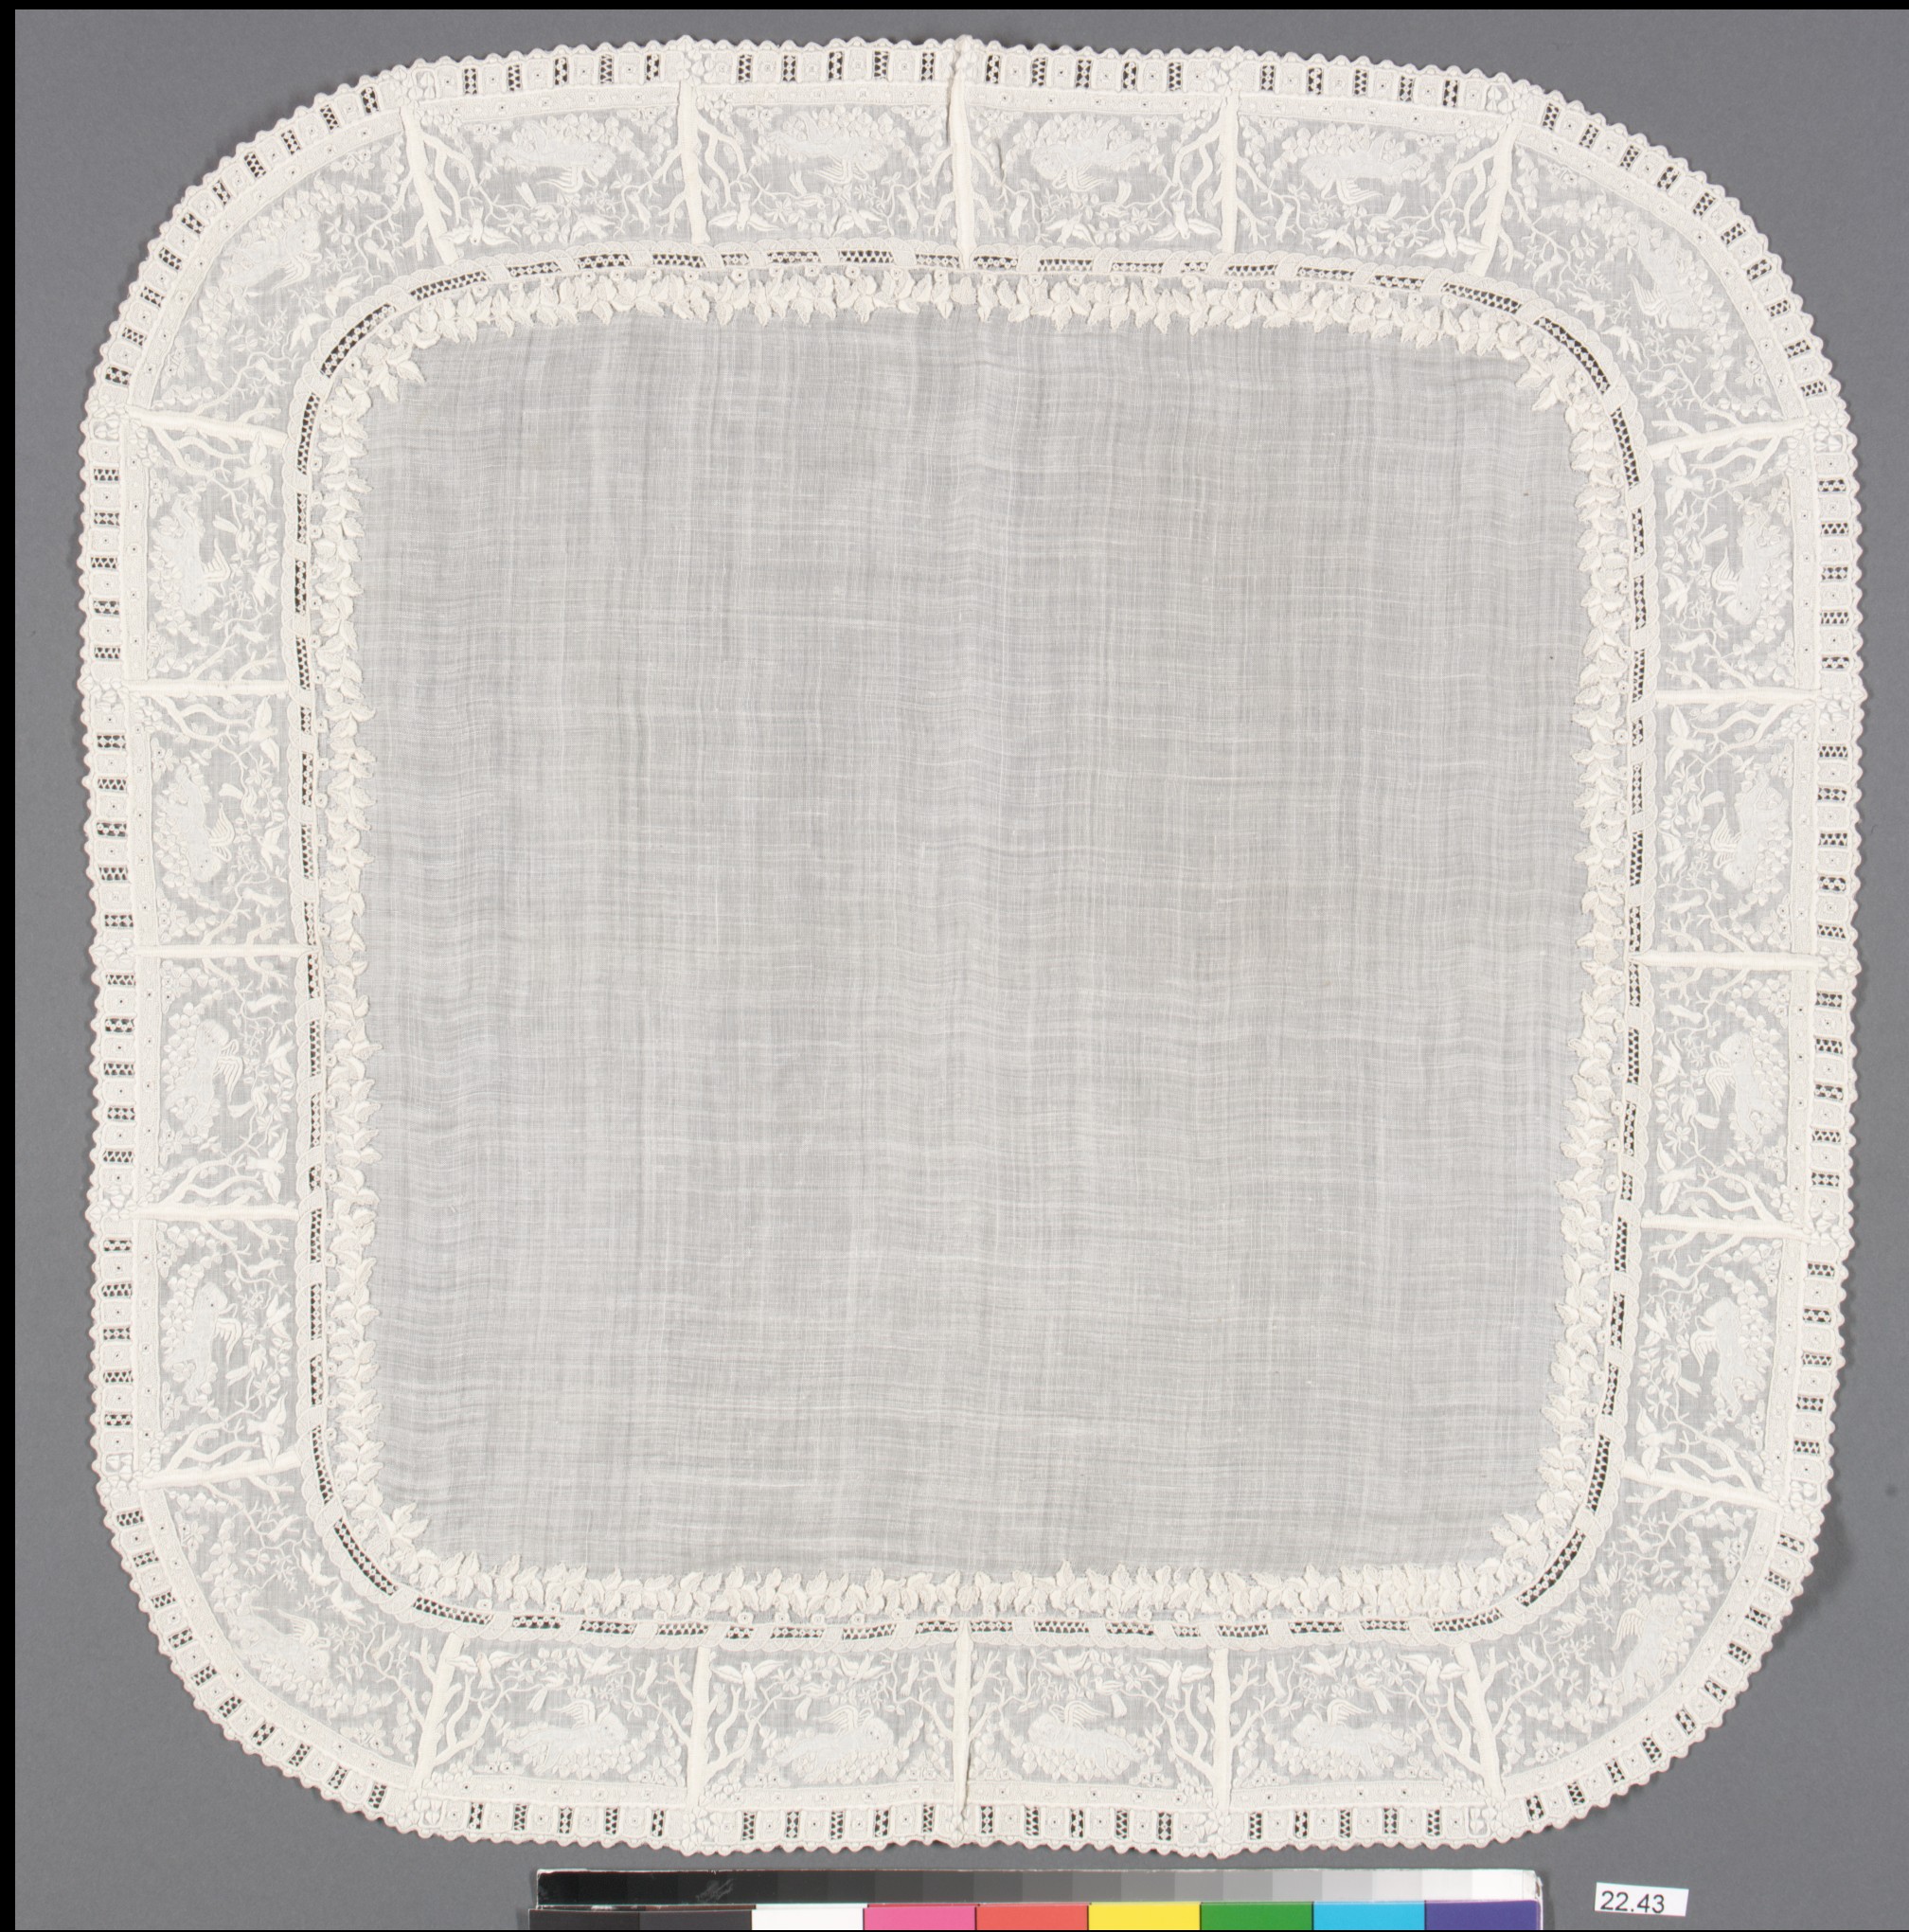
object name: handkerchief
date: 1801-1900